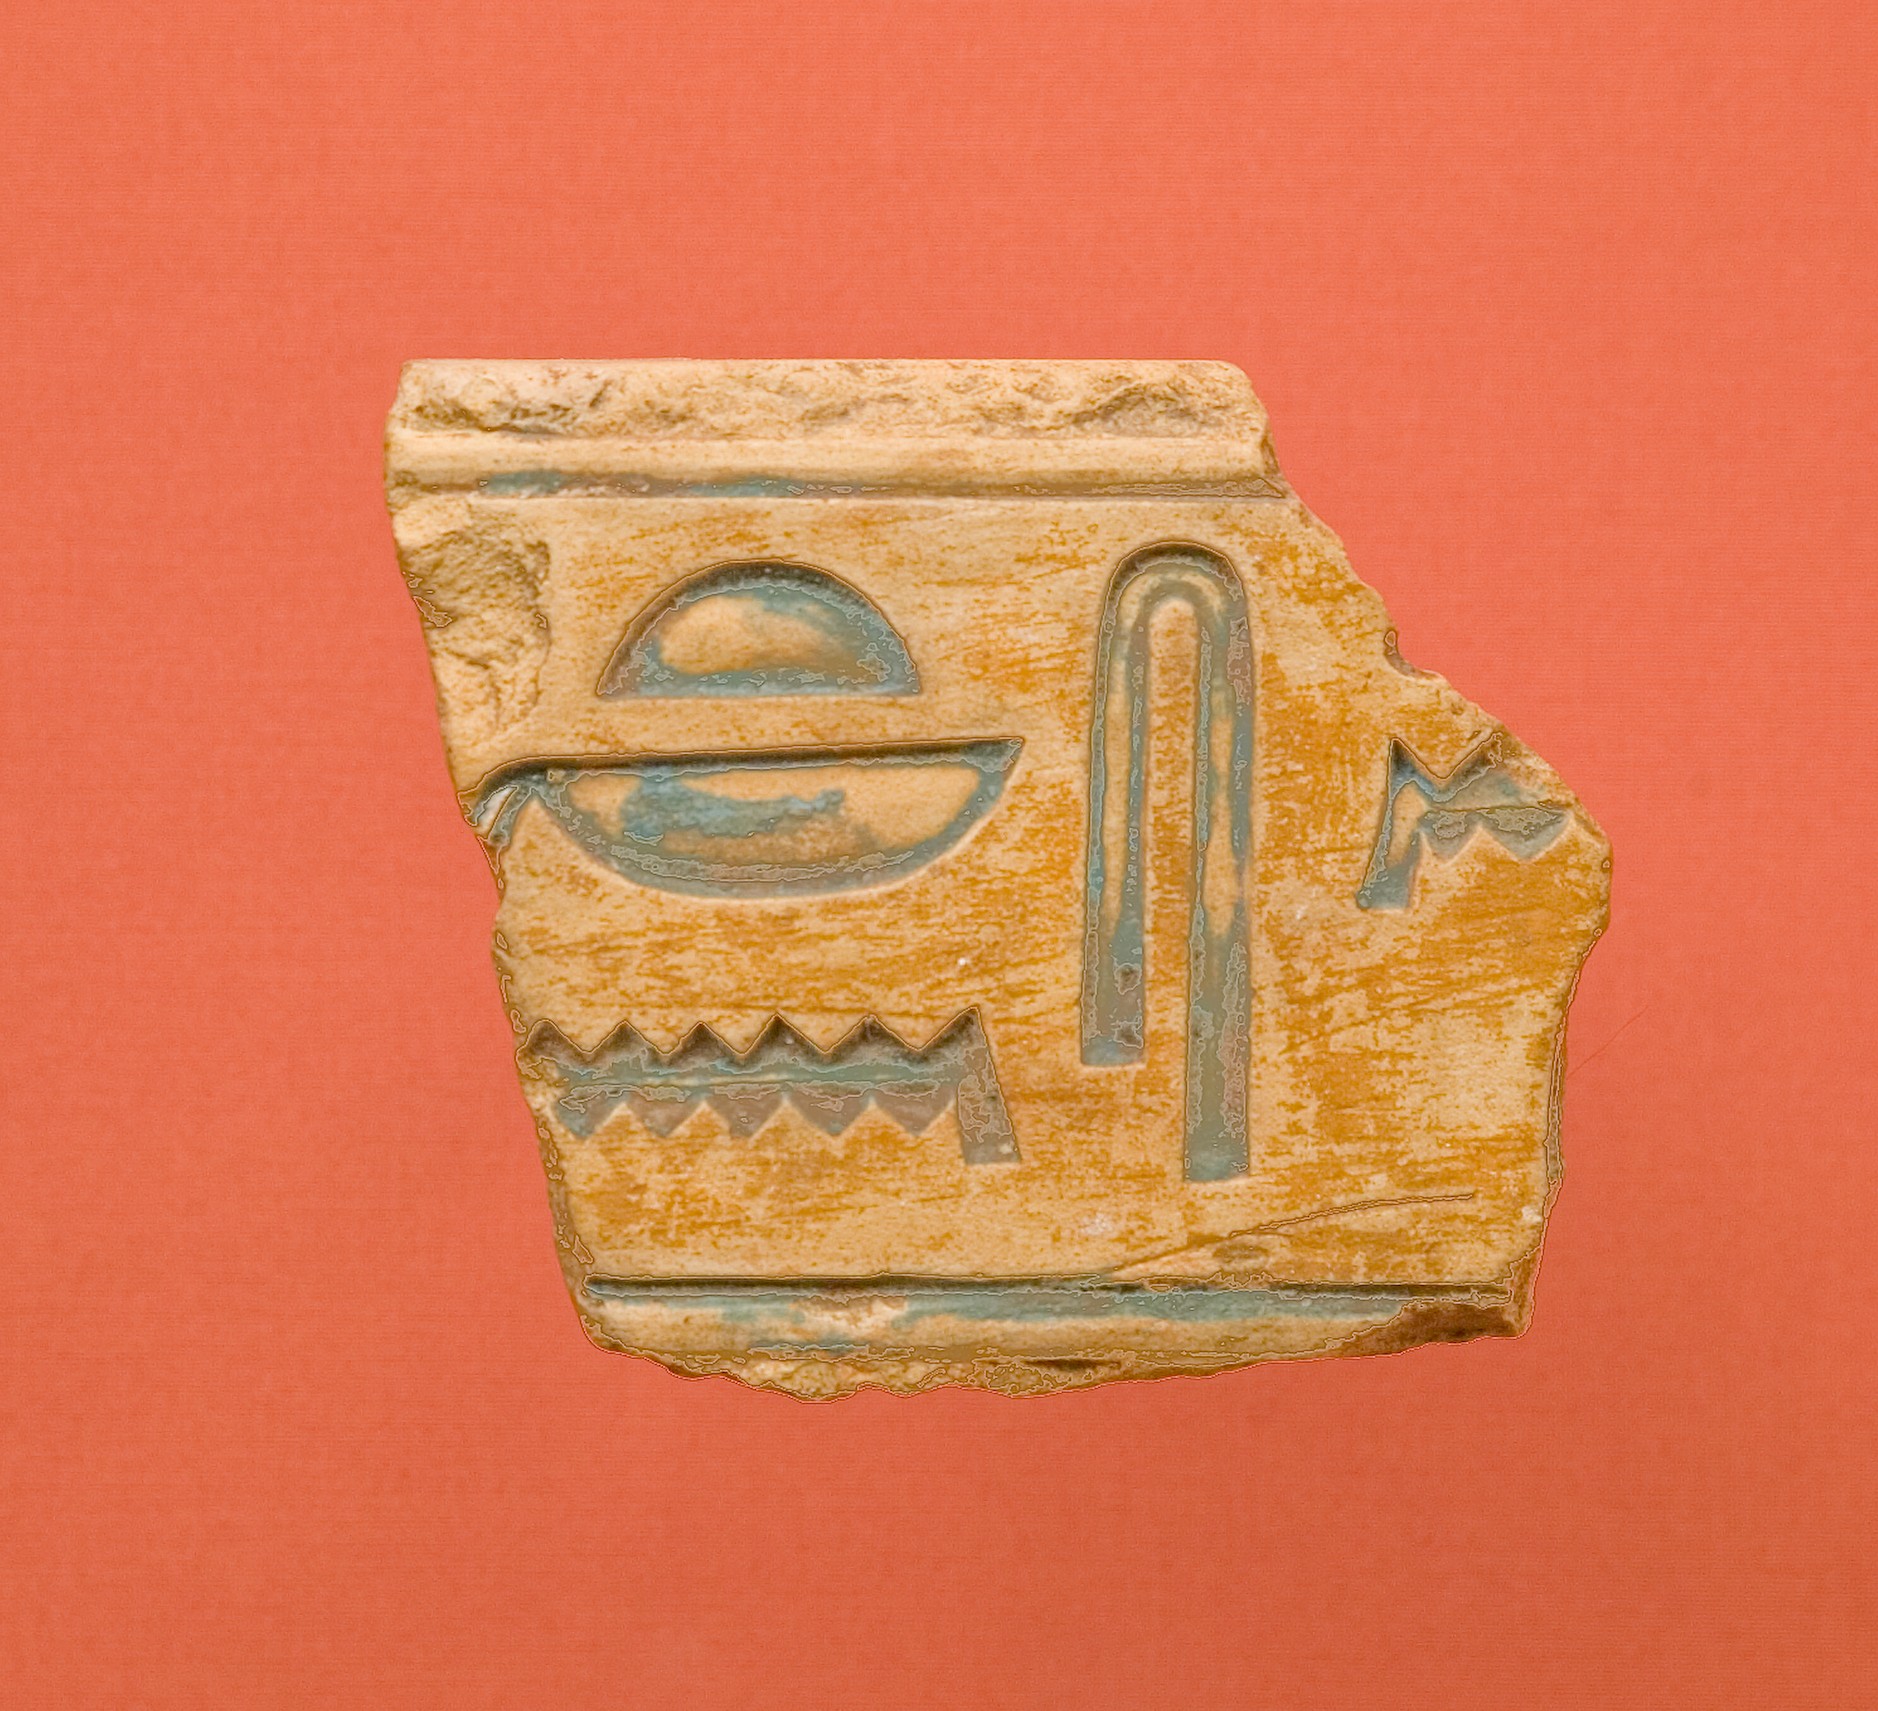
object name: relief, nebhepetre mentuhotep's wife, shrine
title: Inscribed relief fragment from the shrine of a royal woman within the temple of Mentuhotep II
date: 2051-2030 BCE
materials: limestone, paint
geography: egypt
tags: hieroglyphs